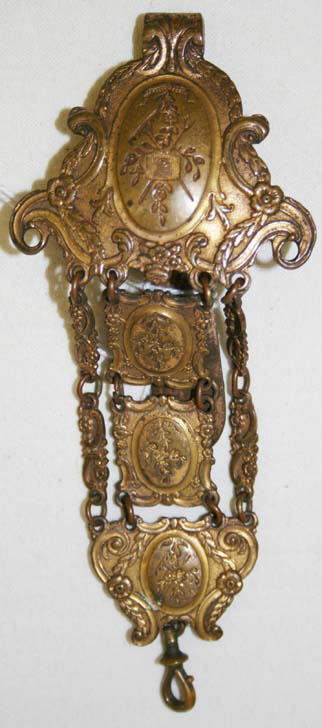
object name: fob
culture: european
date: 1767-1800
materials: brass